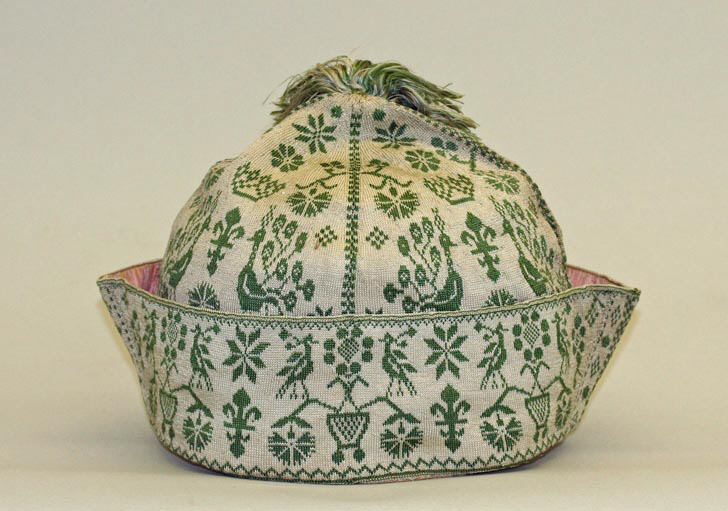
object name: cap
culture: italian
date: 1601-1700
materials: silk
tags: peacocks